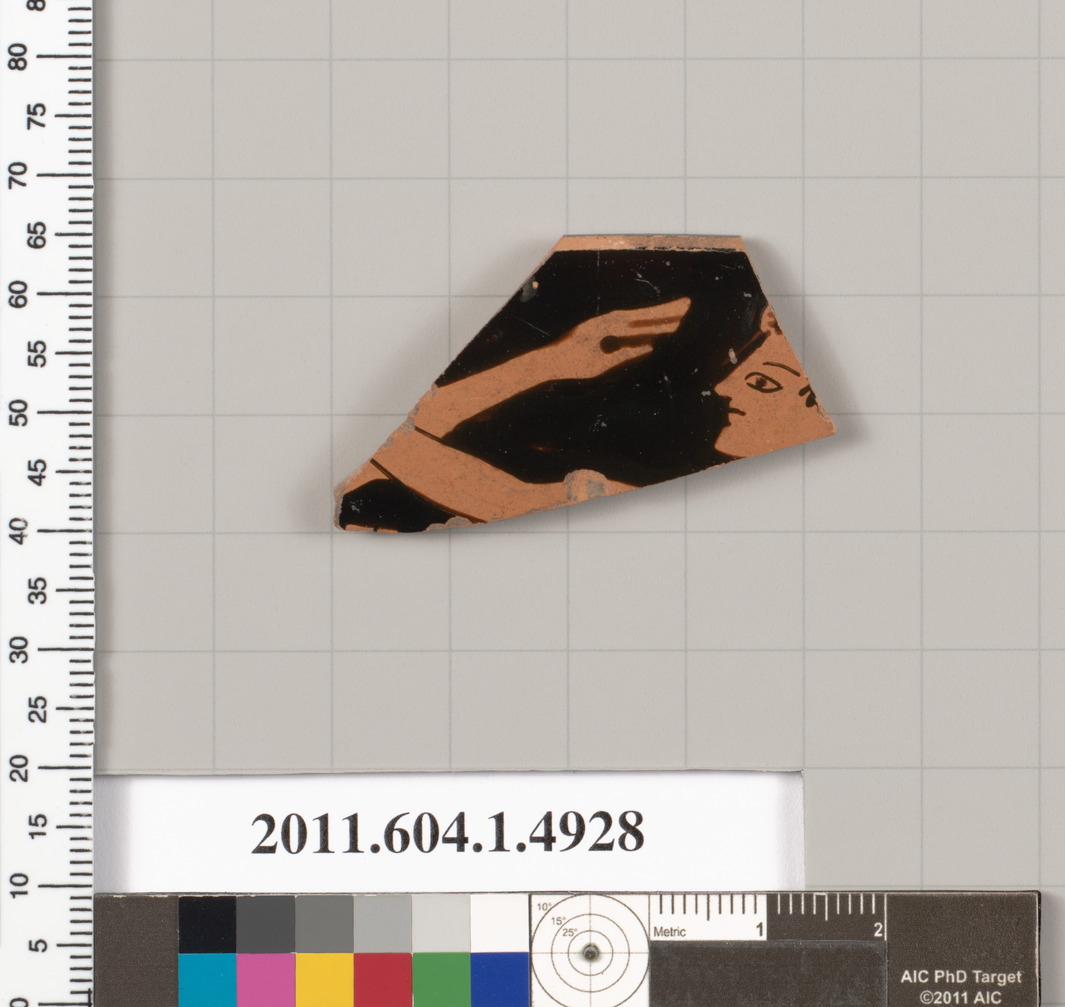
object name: kylix fragment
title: Terracotta rim fragment of a kylix (drinking cup)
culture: greek, attic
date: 520-500 BCE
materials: terracotta